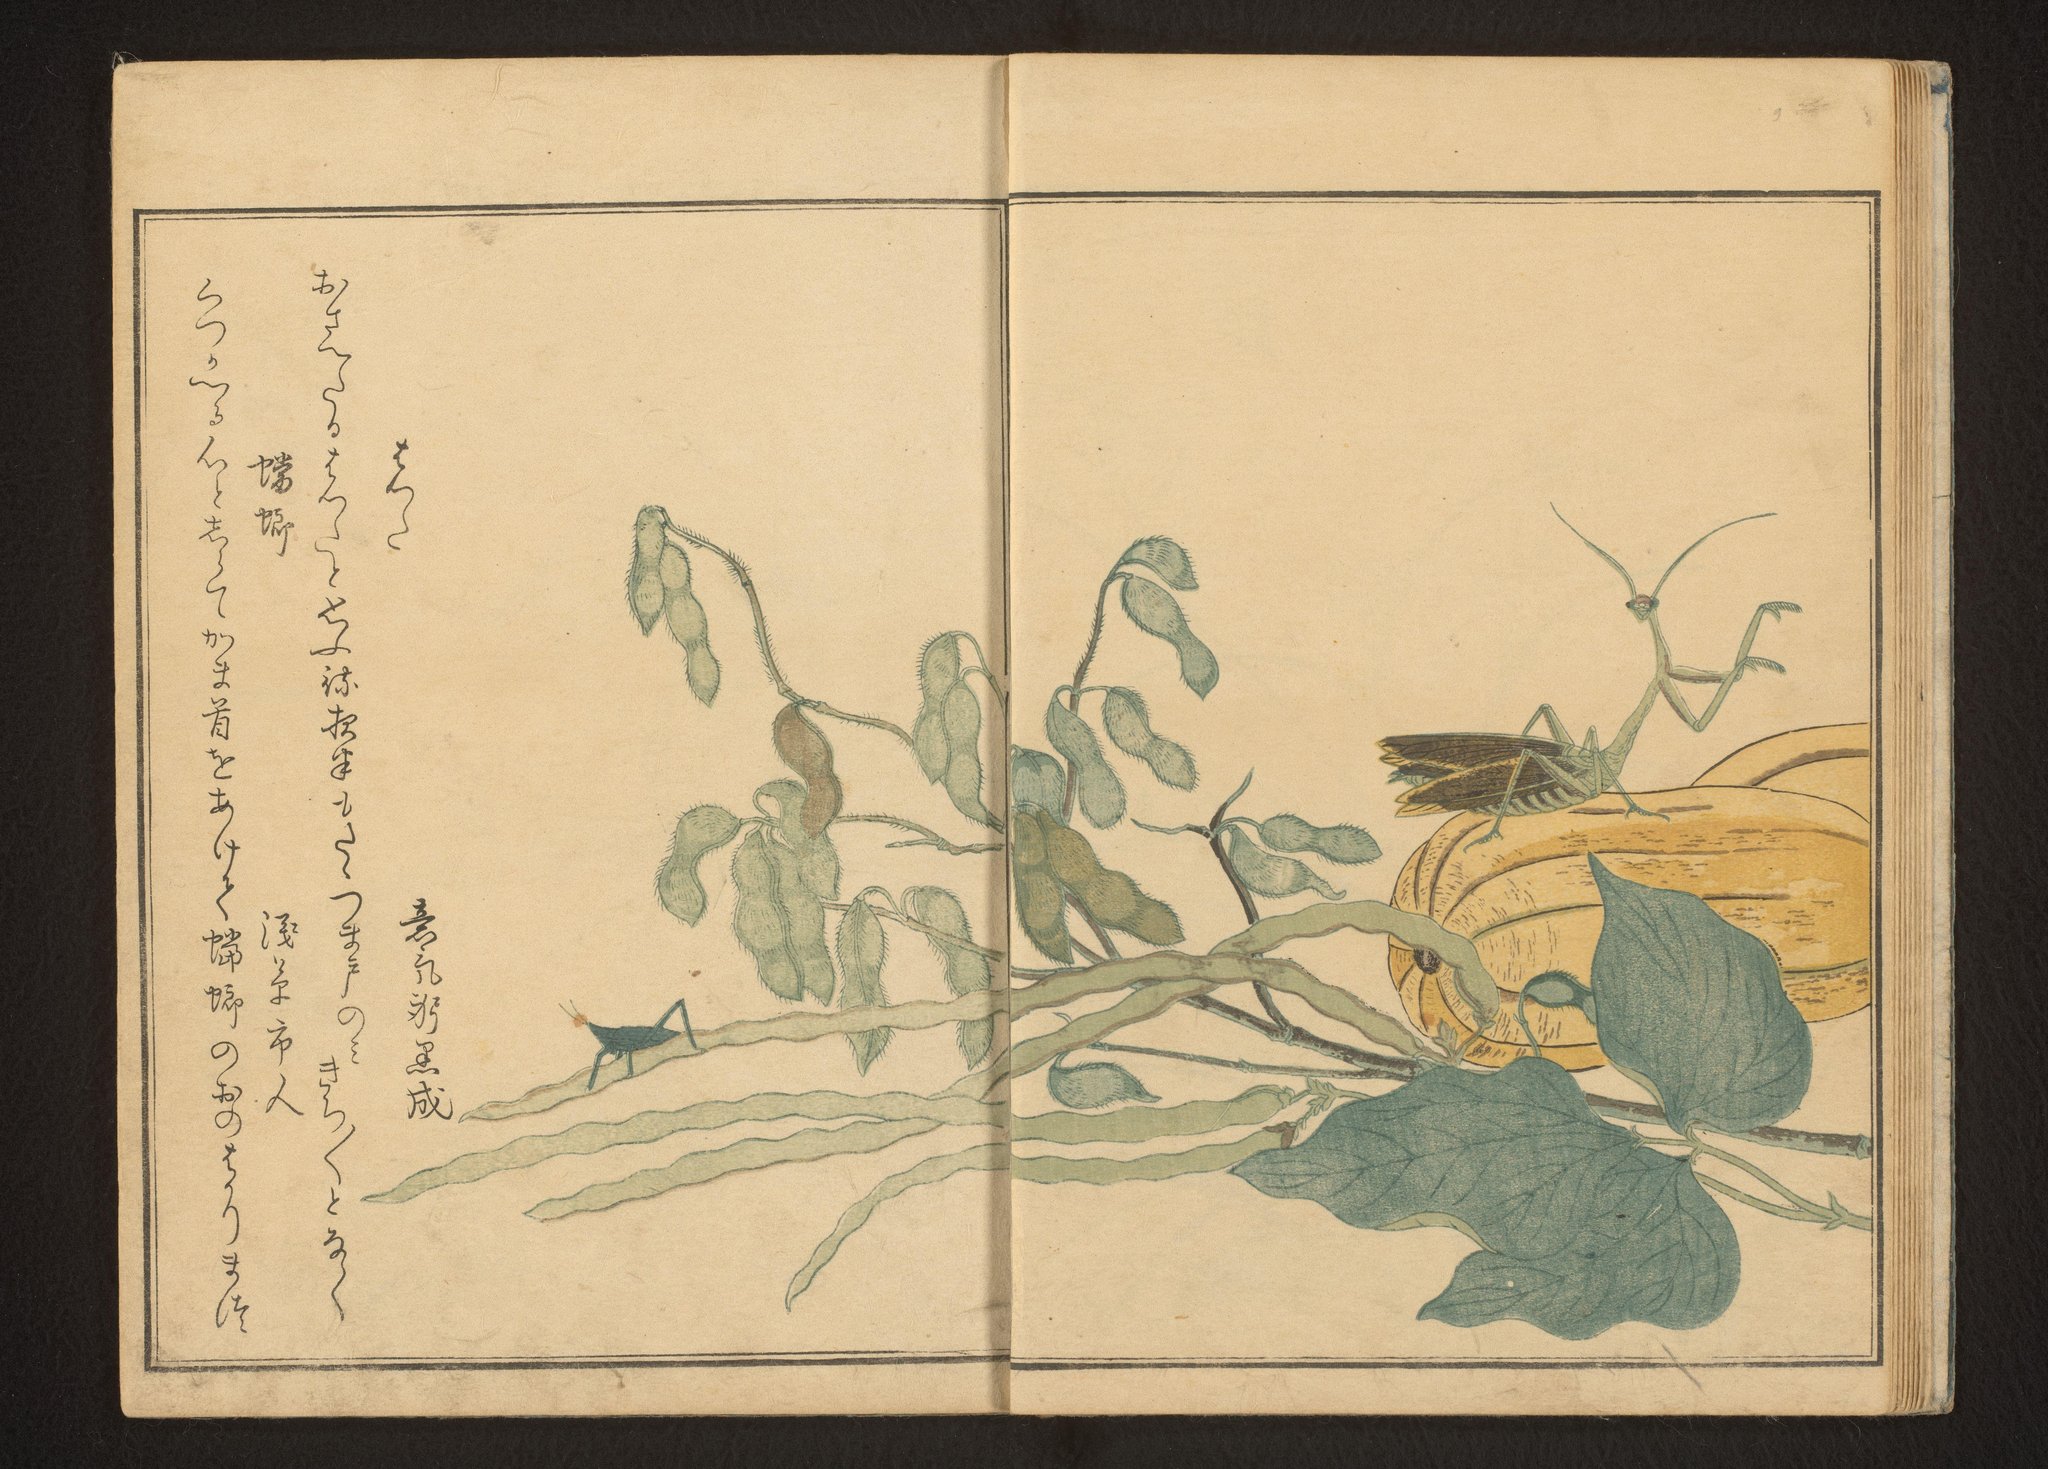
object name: page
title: Grasshopper on bean and praying mantis on melon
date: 1788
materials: paper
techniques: woodcut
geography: edo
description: Pagina 8b en 9a in deel één van het Insectenboek van Utamaro.